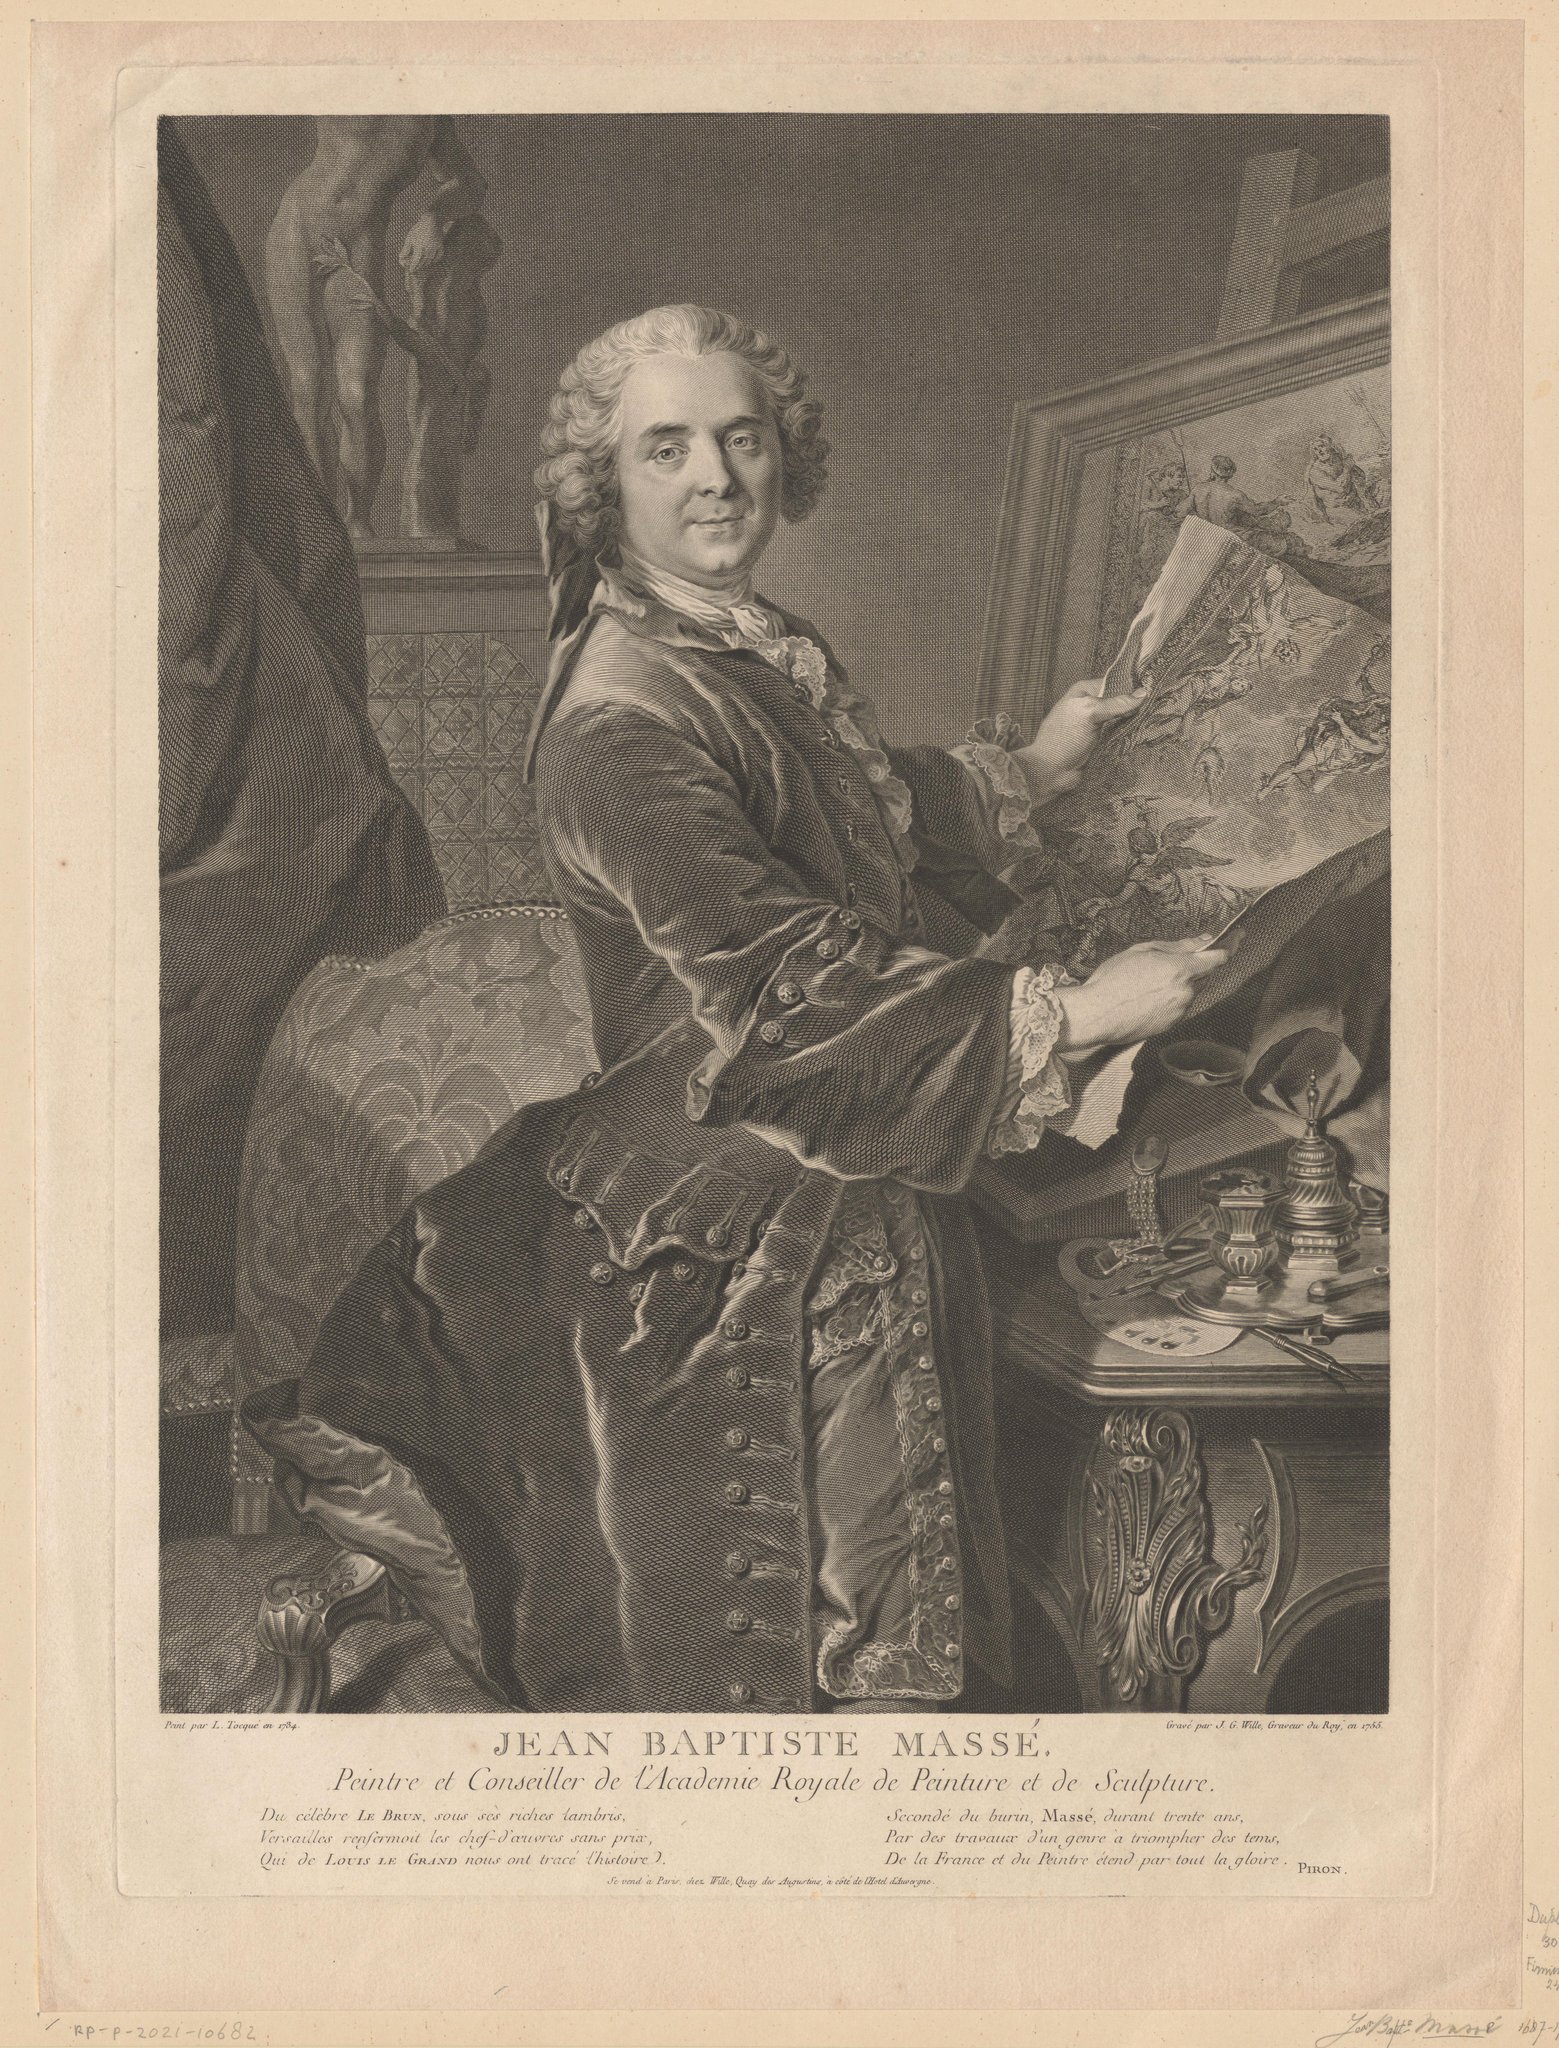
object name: print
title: Portret van Jean-Baptiste Massé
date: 1755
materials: paper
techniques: engraving, etching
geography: france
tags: paris, painter, print maker, draughtsman, print, e.g.: engraving, etching, lithograph, historical persons, portrait, self-portrait of painter, piece of sculpture, reproduction of a piece of sculpture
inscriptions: date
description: Met zesregelig vers in het Frans in twee kolommen.